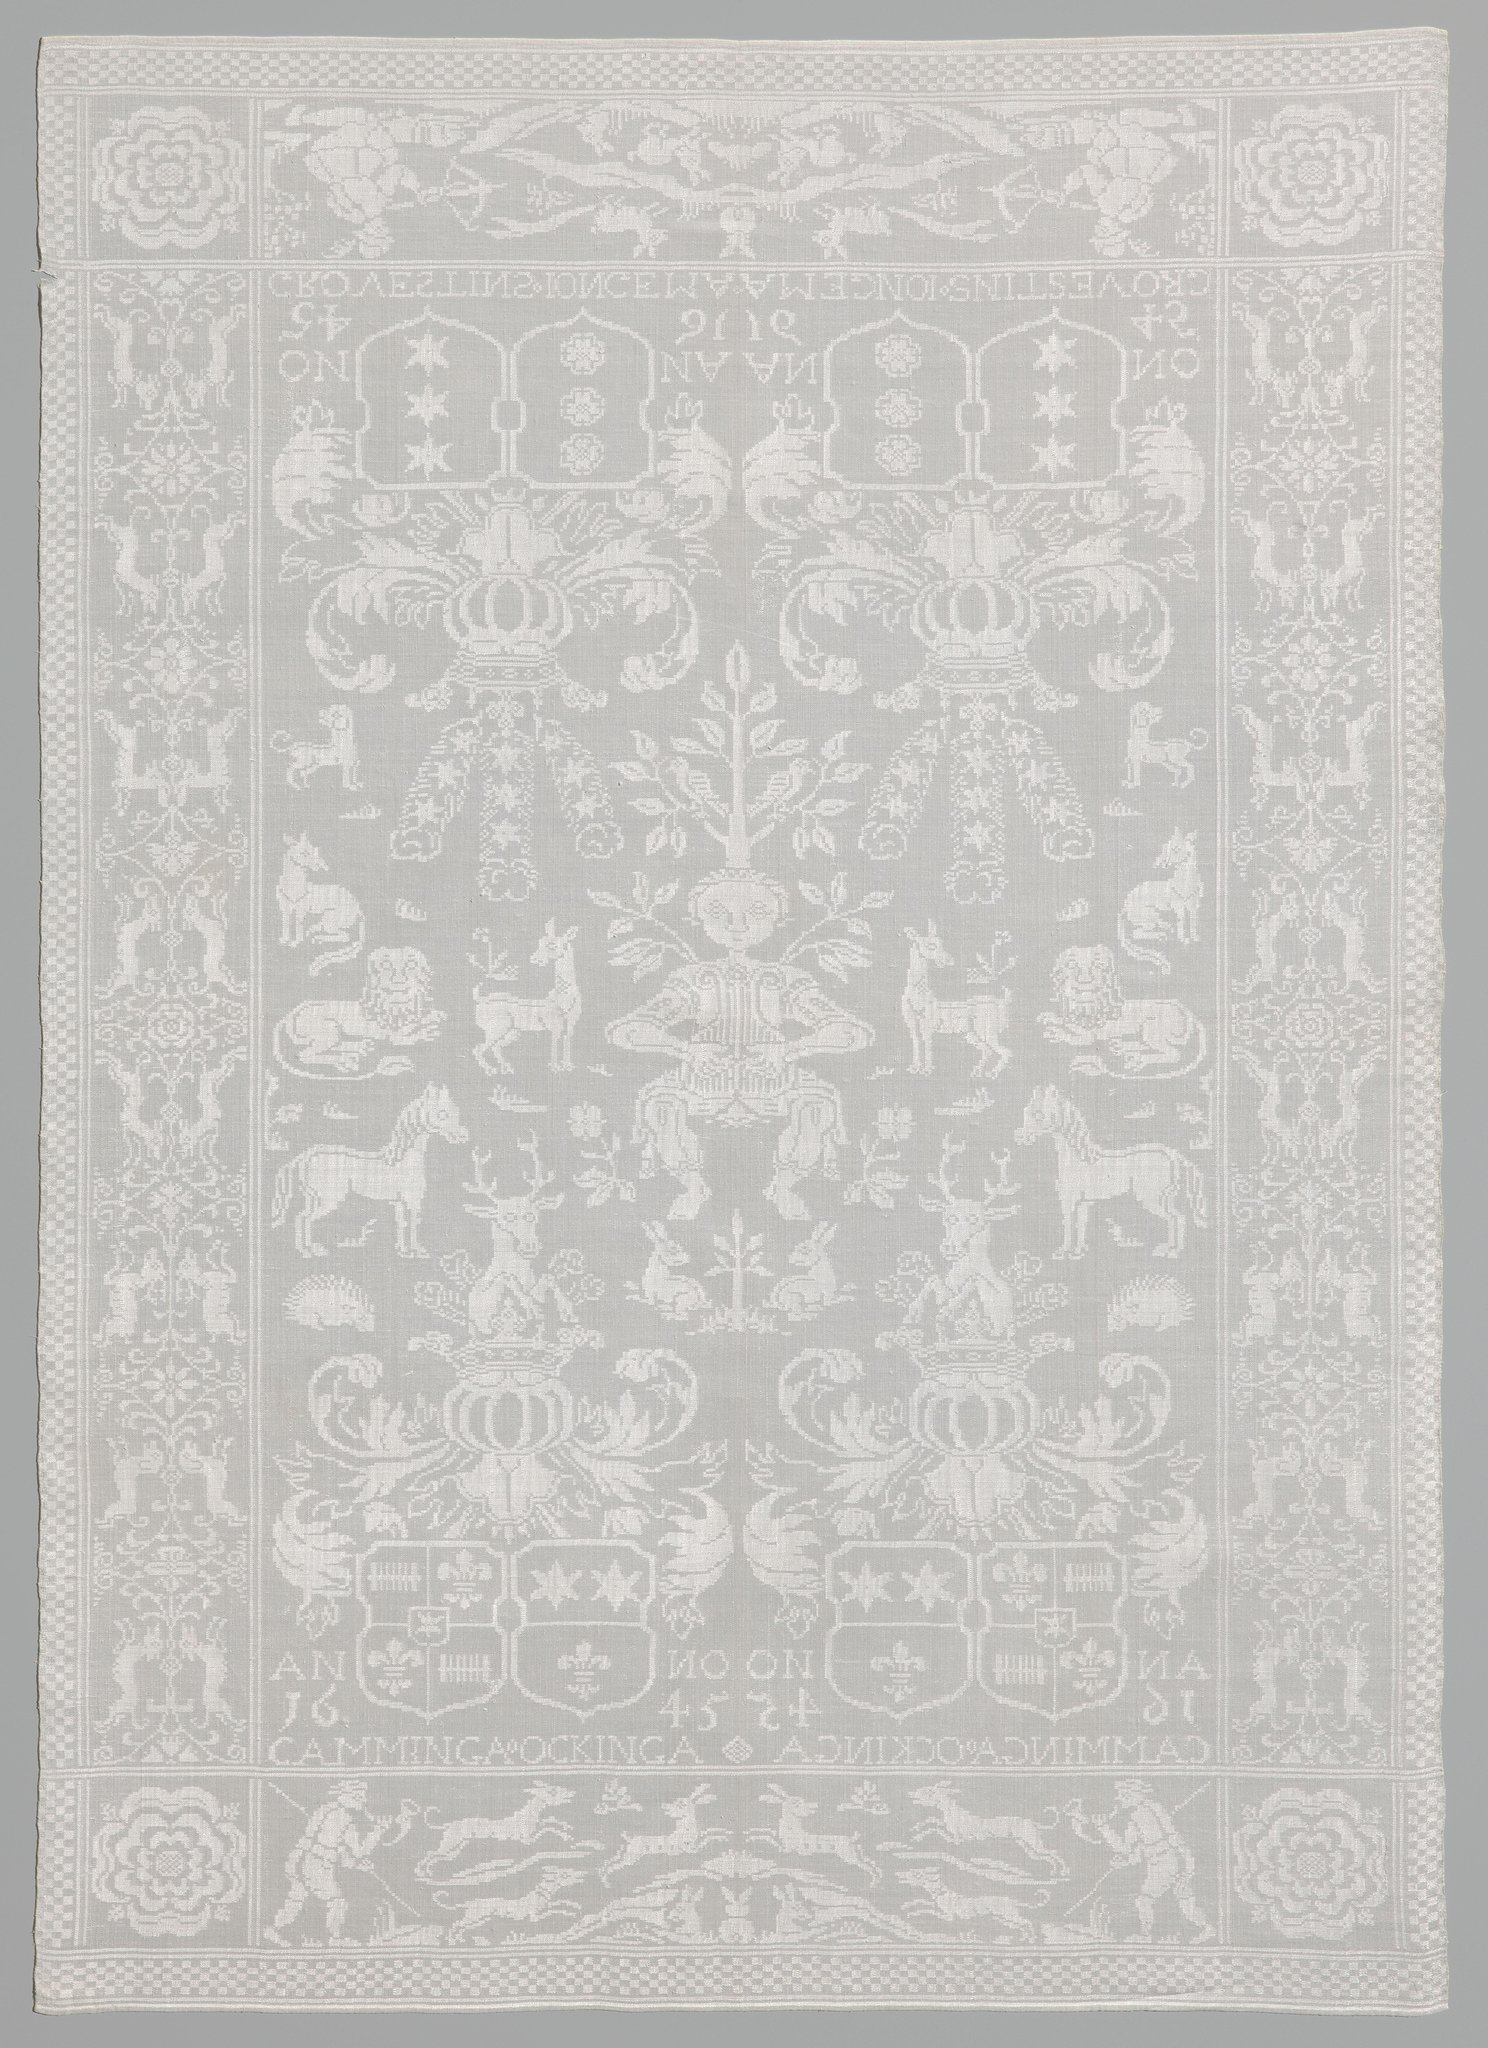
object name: napkin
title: Servet met Friese wapens en Orpheus te midden van de dieren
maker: quirijn jansz. damast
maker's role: mayor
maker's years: 1580-1638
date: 1645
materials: linen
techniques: damask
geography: haarlem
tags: orpheus playing the lyre: trees and rocks move, beasts and birds are enchanted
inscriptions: date